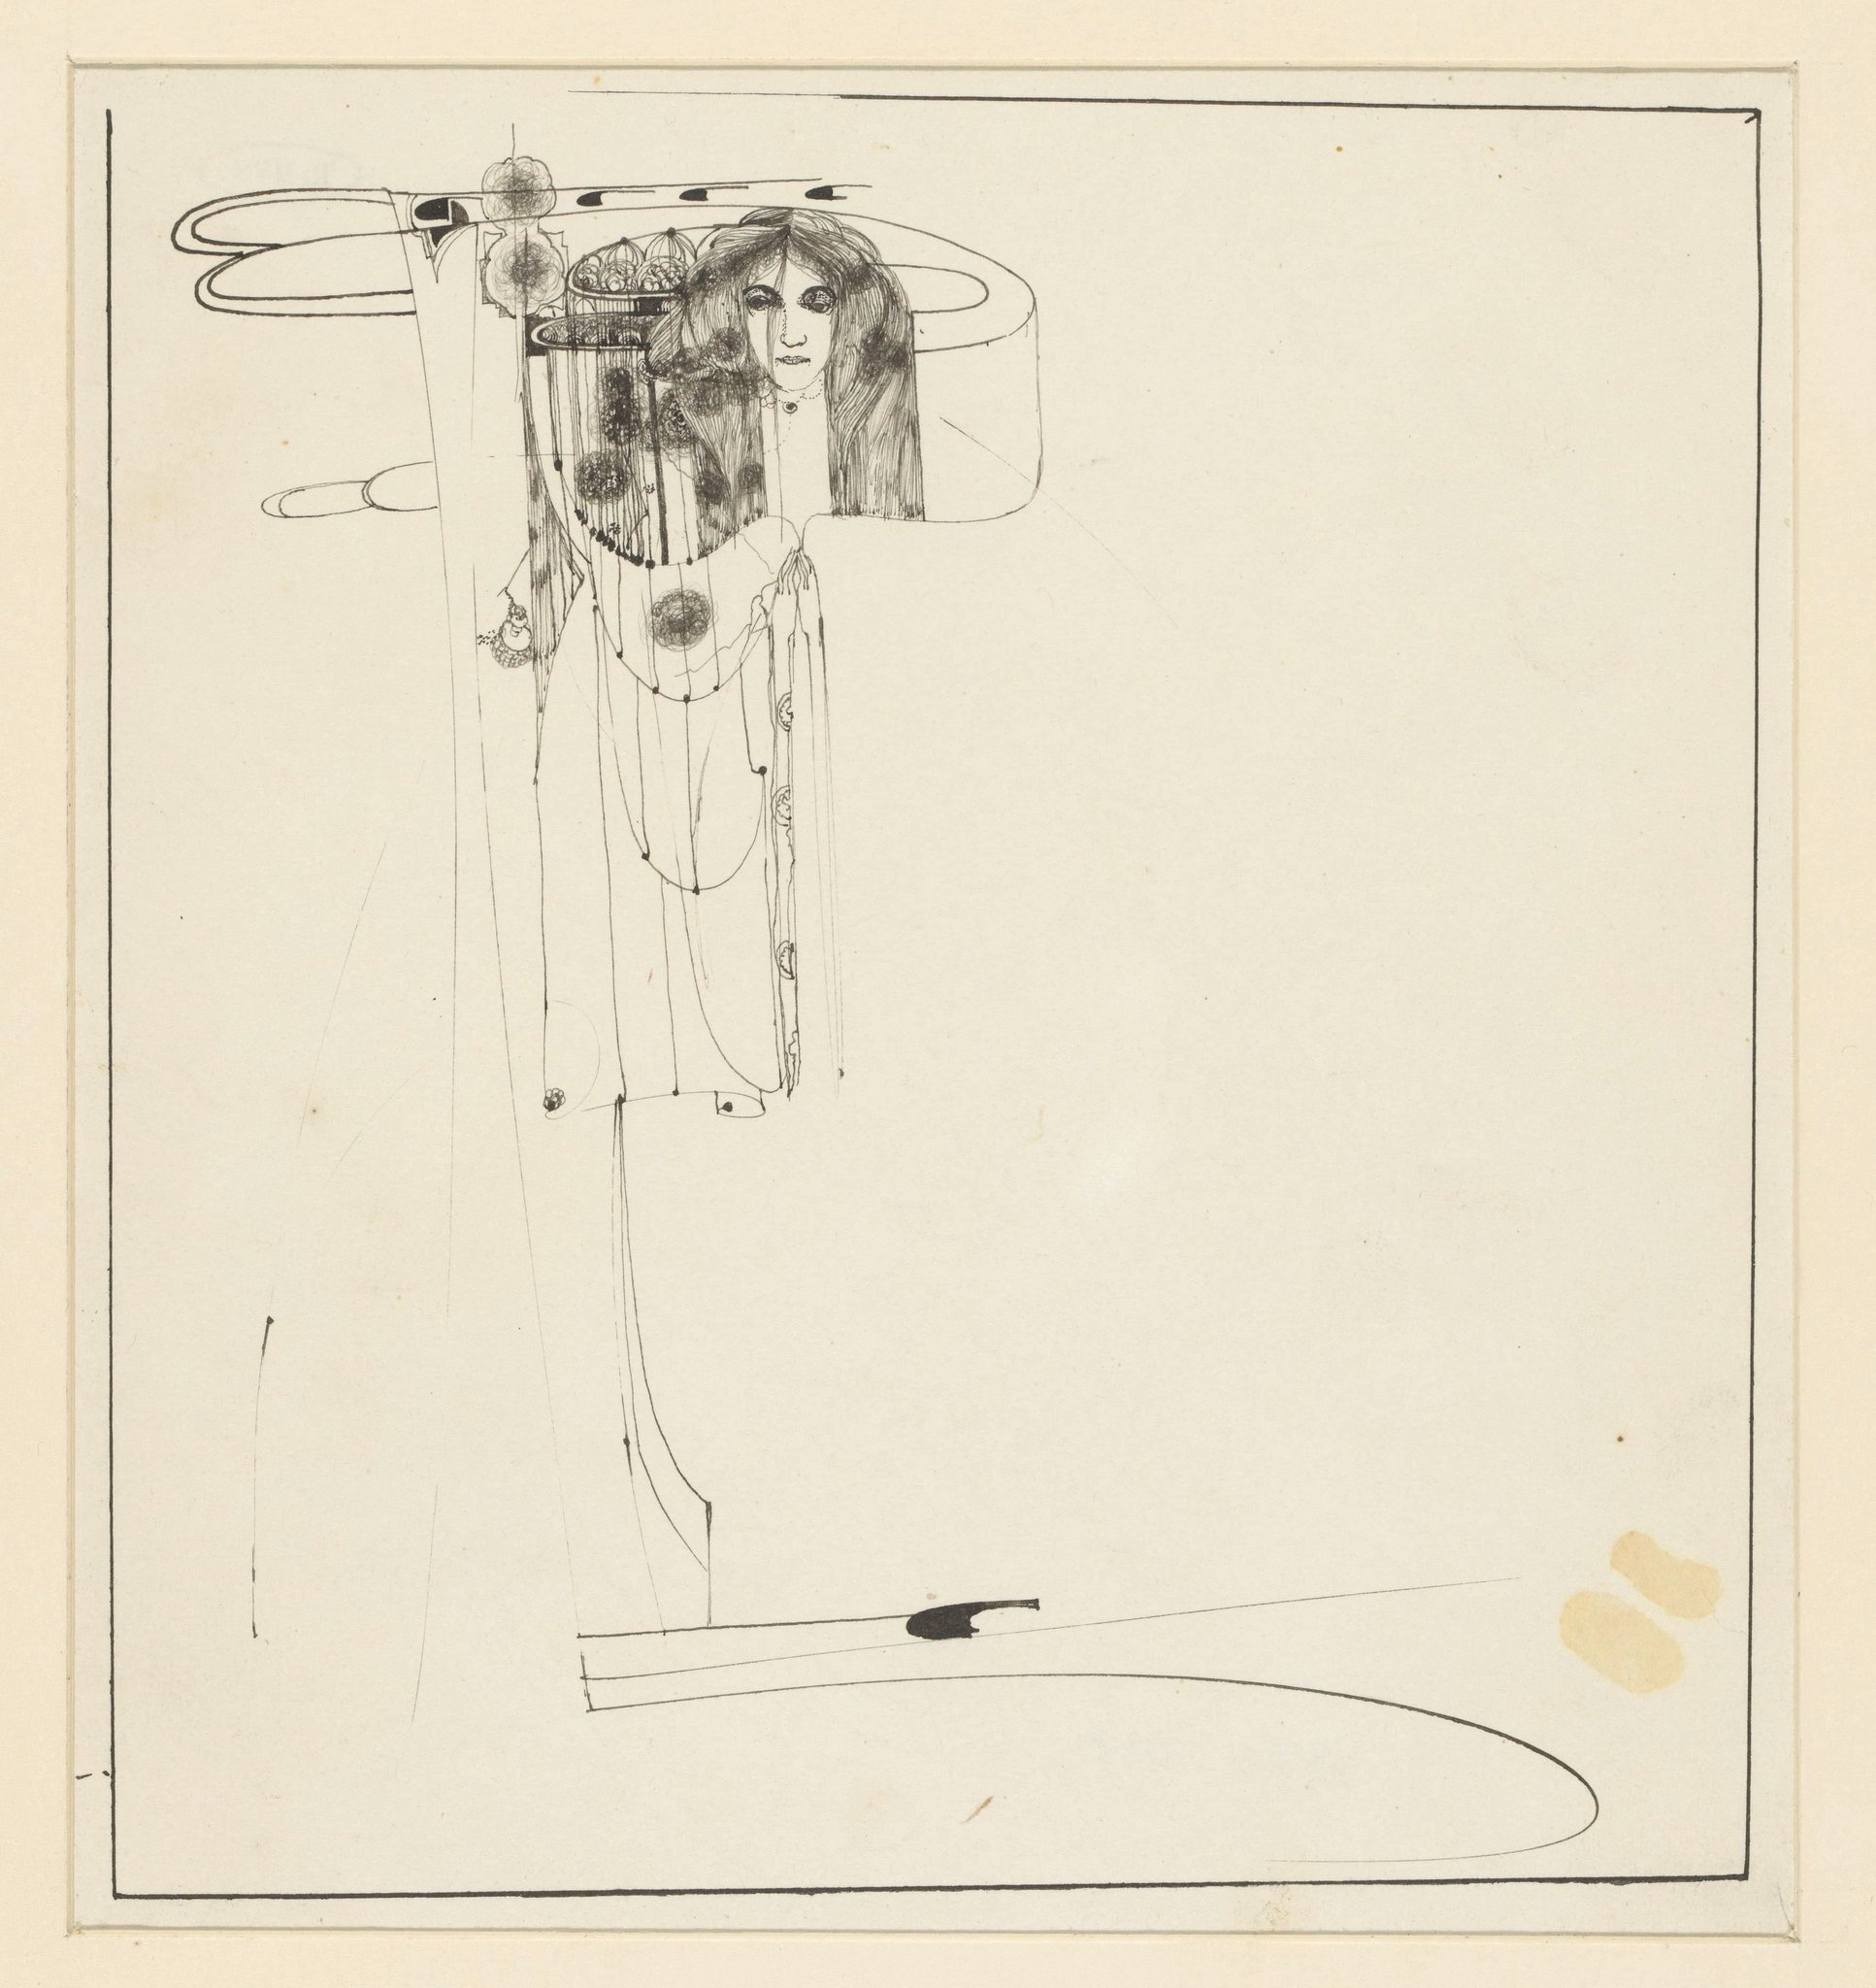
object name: drawing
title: Ornament met vrouwenhoofd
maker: karel de nerée tot babberich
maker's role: draughtsman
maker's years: 1880-1909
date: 1890-1909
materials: ink, paper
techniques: pen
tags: ornament ~ human parts, female sex; woman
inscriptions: collector's mark: Lugt 2228